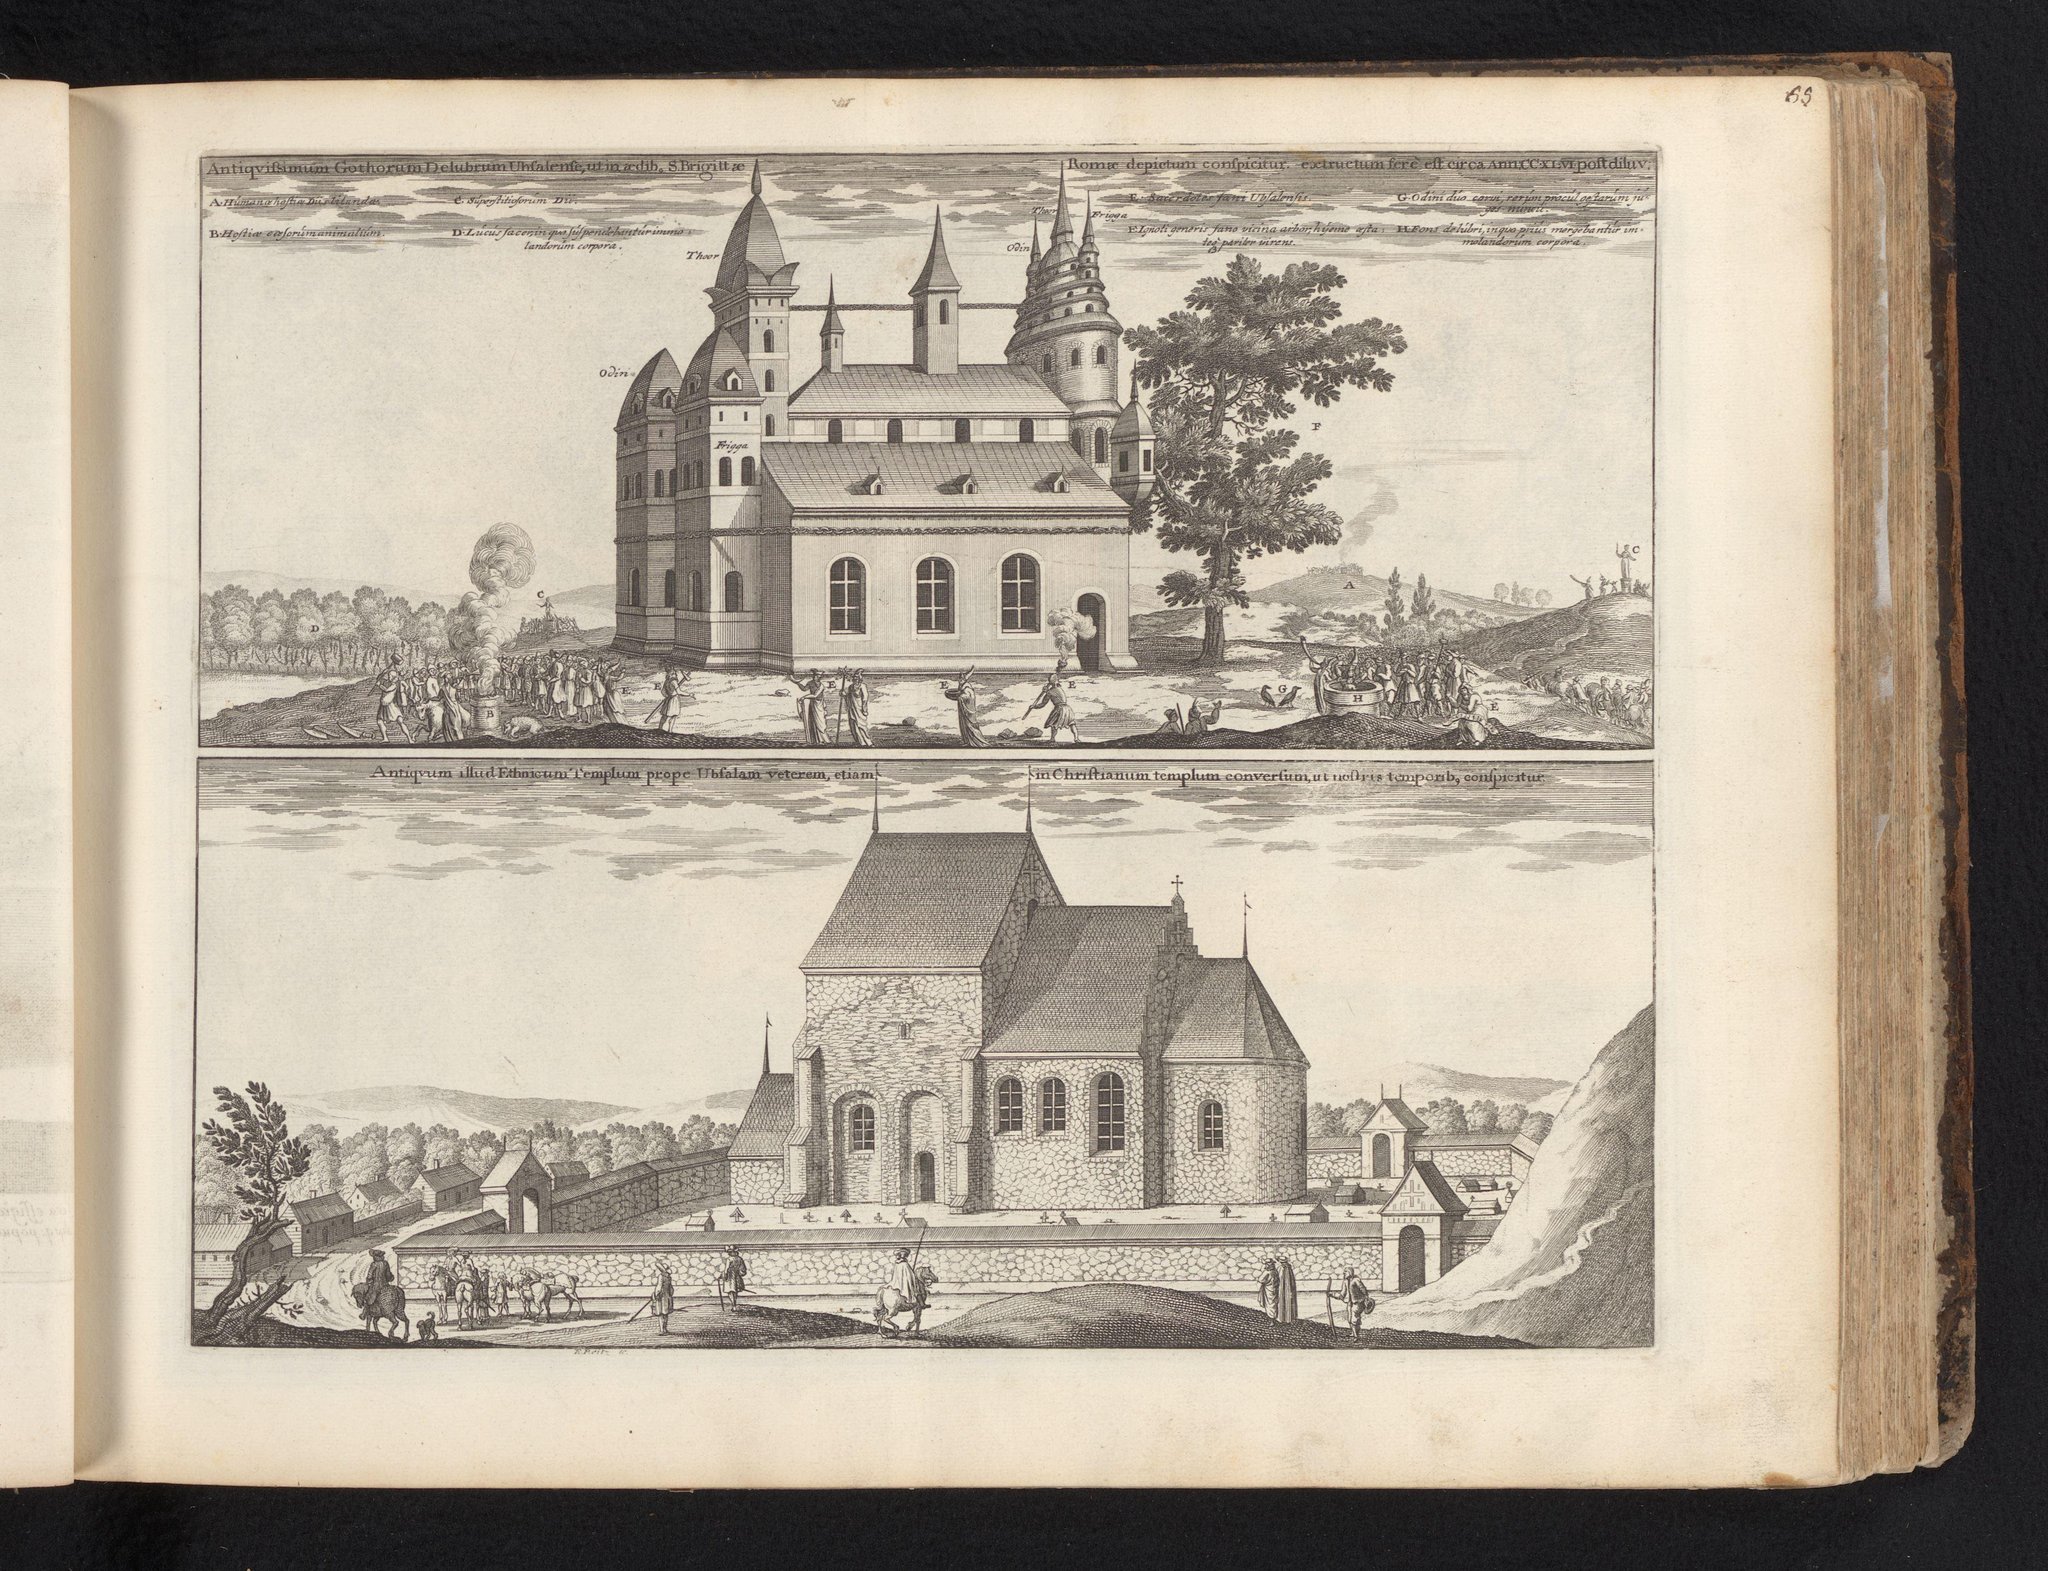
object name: album leaf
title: Antiquissimum Gothorum Delubrum Ubsalense (...)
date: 1694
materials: paper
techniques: etching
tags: uppsala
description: Kungliga Biblioteket, 'Suecia': http://www.kb.se/samlingarna/Kartor-bilder/Suecia-antiqua/ (geraadpleegd november 2016).